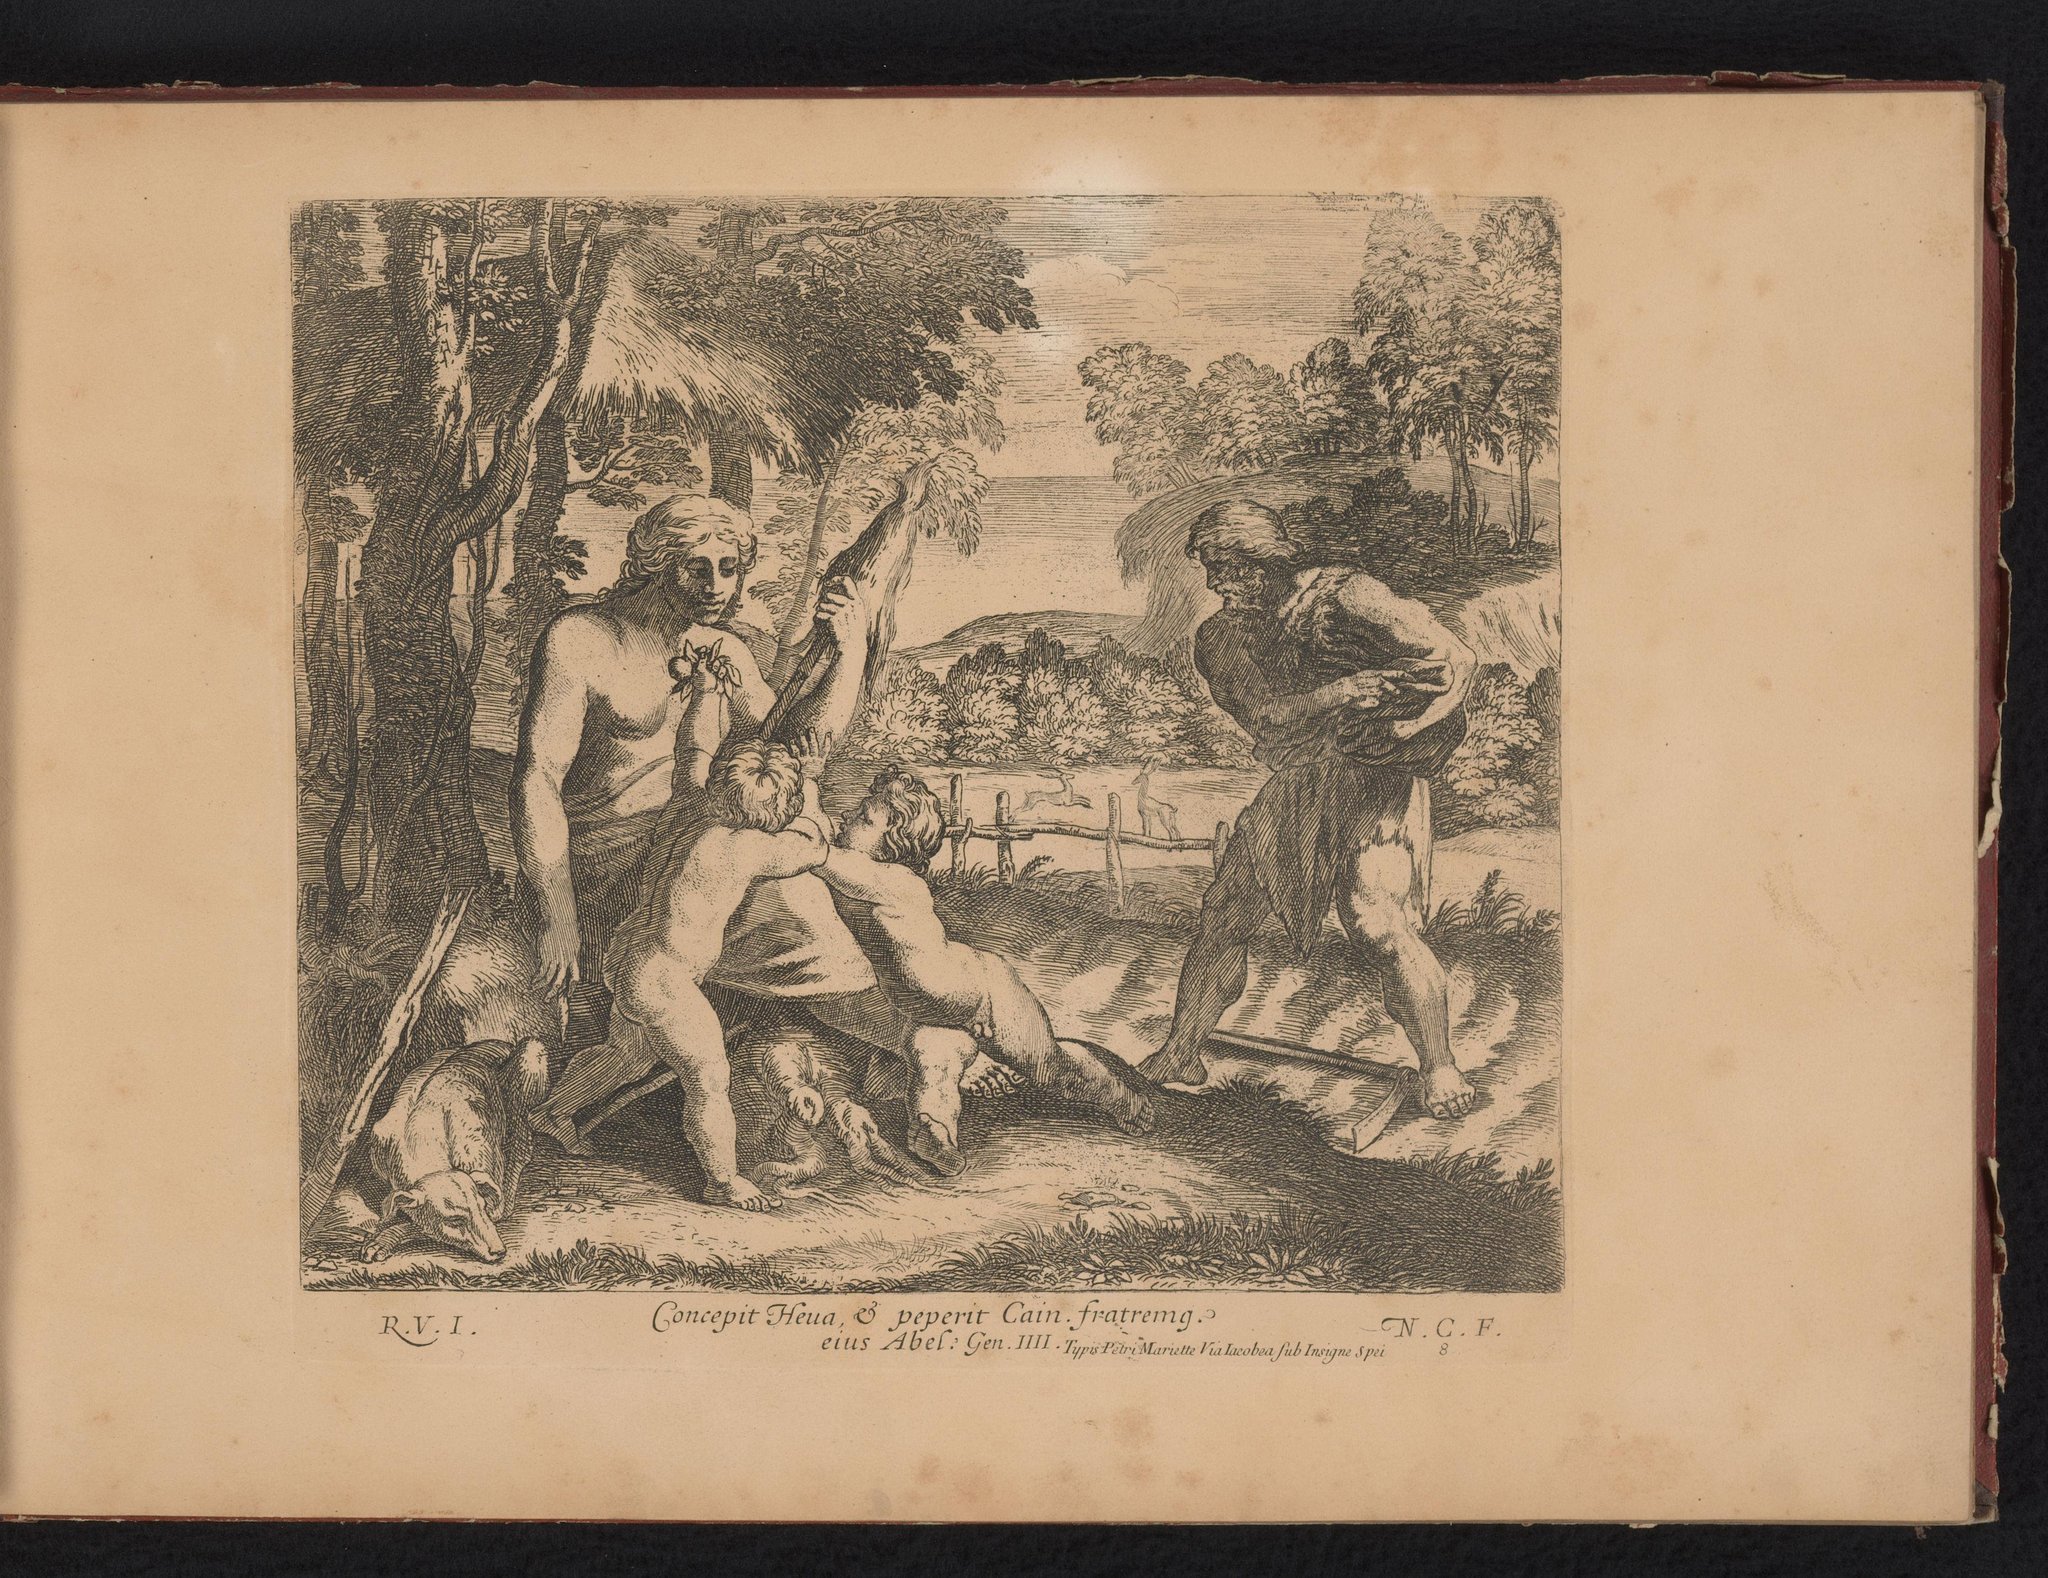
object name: print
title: Sacrae historiae acta a Raphael Urbin in Vaticanis xystis ad picturae miraculum expressa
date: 1649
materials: paper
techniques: etching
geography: paris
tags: expulsion of adam and eve from paradise (genesis 3:22-24)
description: Deze prent maakt deel uit van een album.